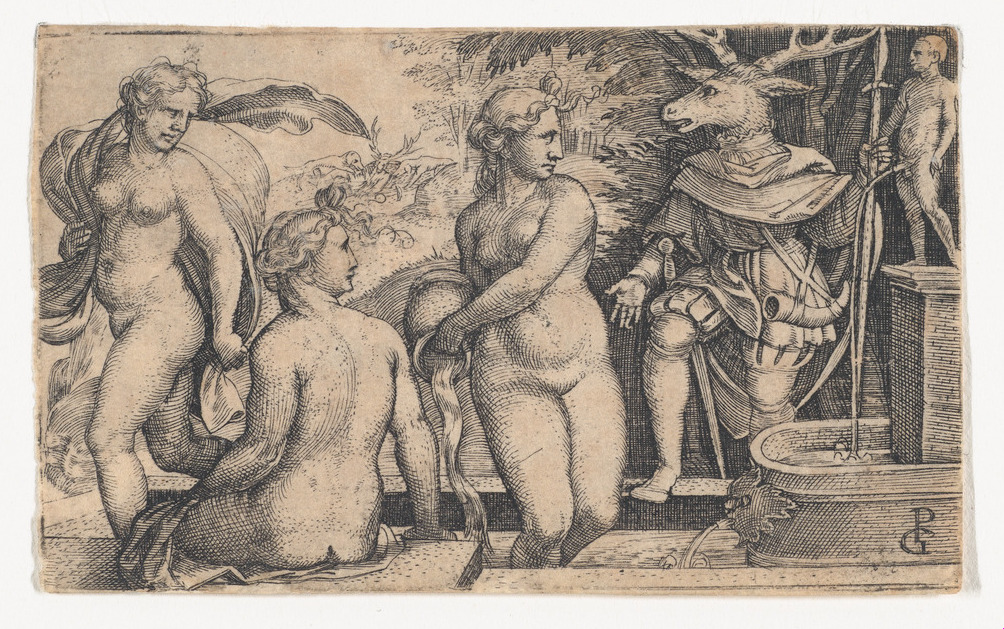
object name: print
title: Diana and Actaeon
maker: georg pencz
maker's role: artist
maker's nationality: german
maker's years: 1500-1550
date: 1528-1538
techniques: engraving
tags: actaeon,diana